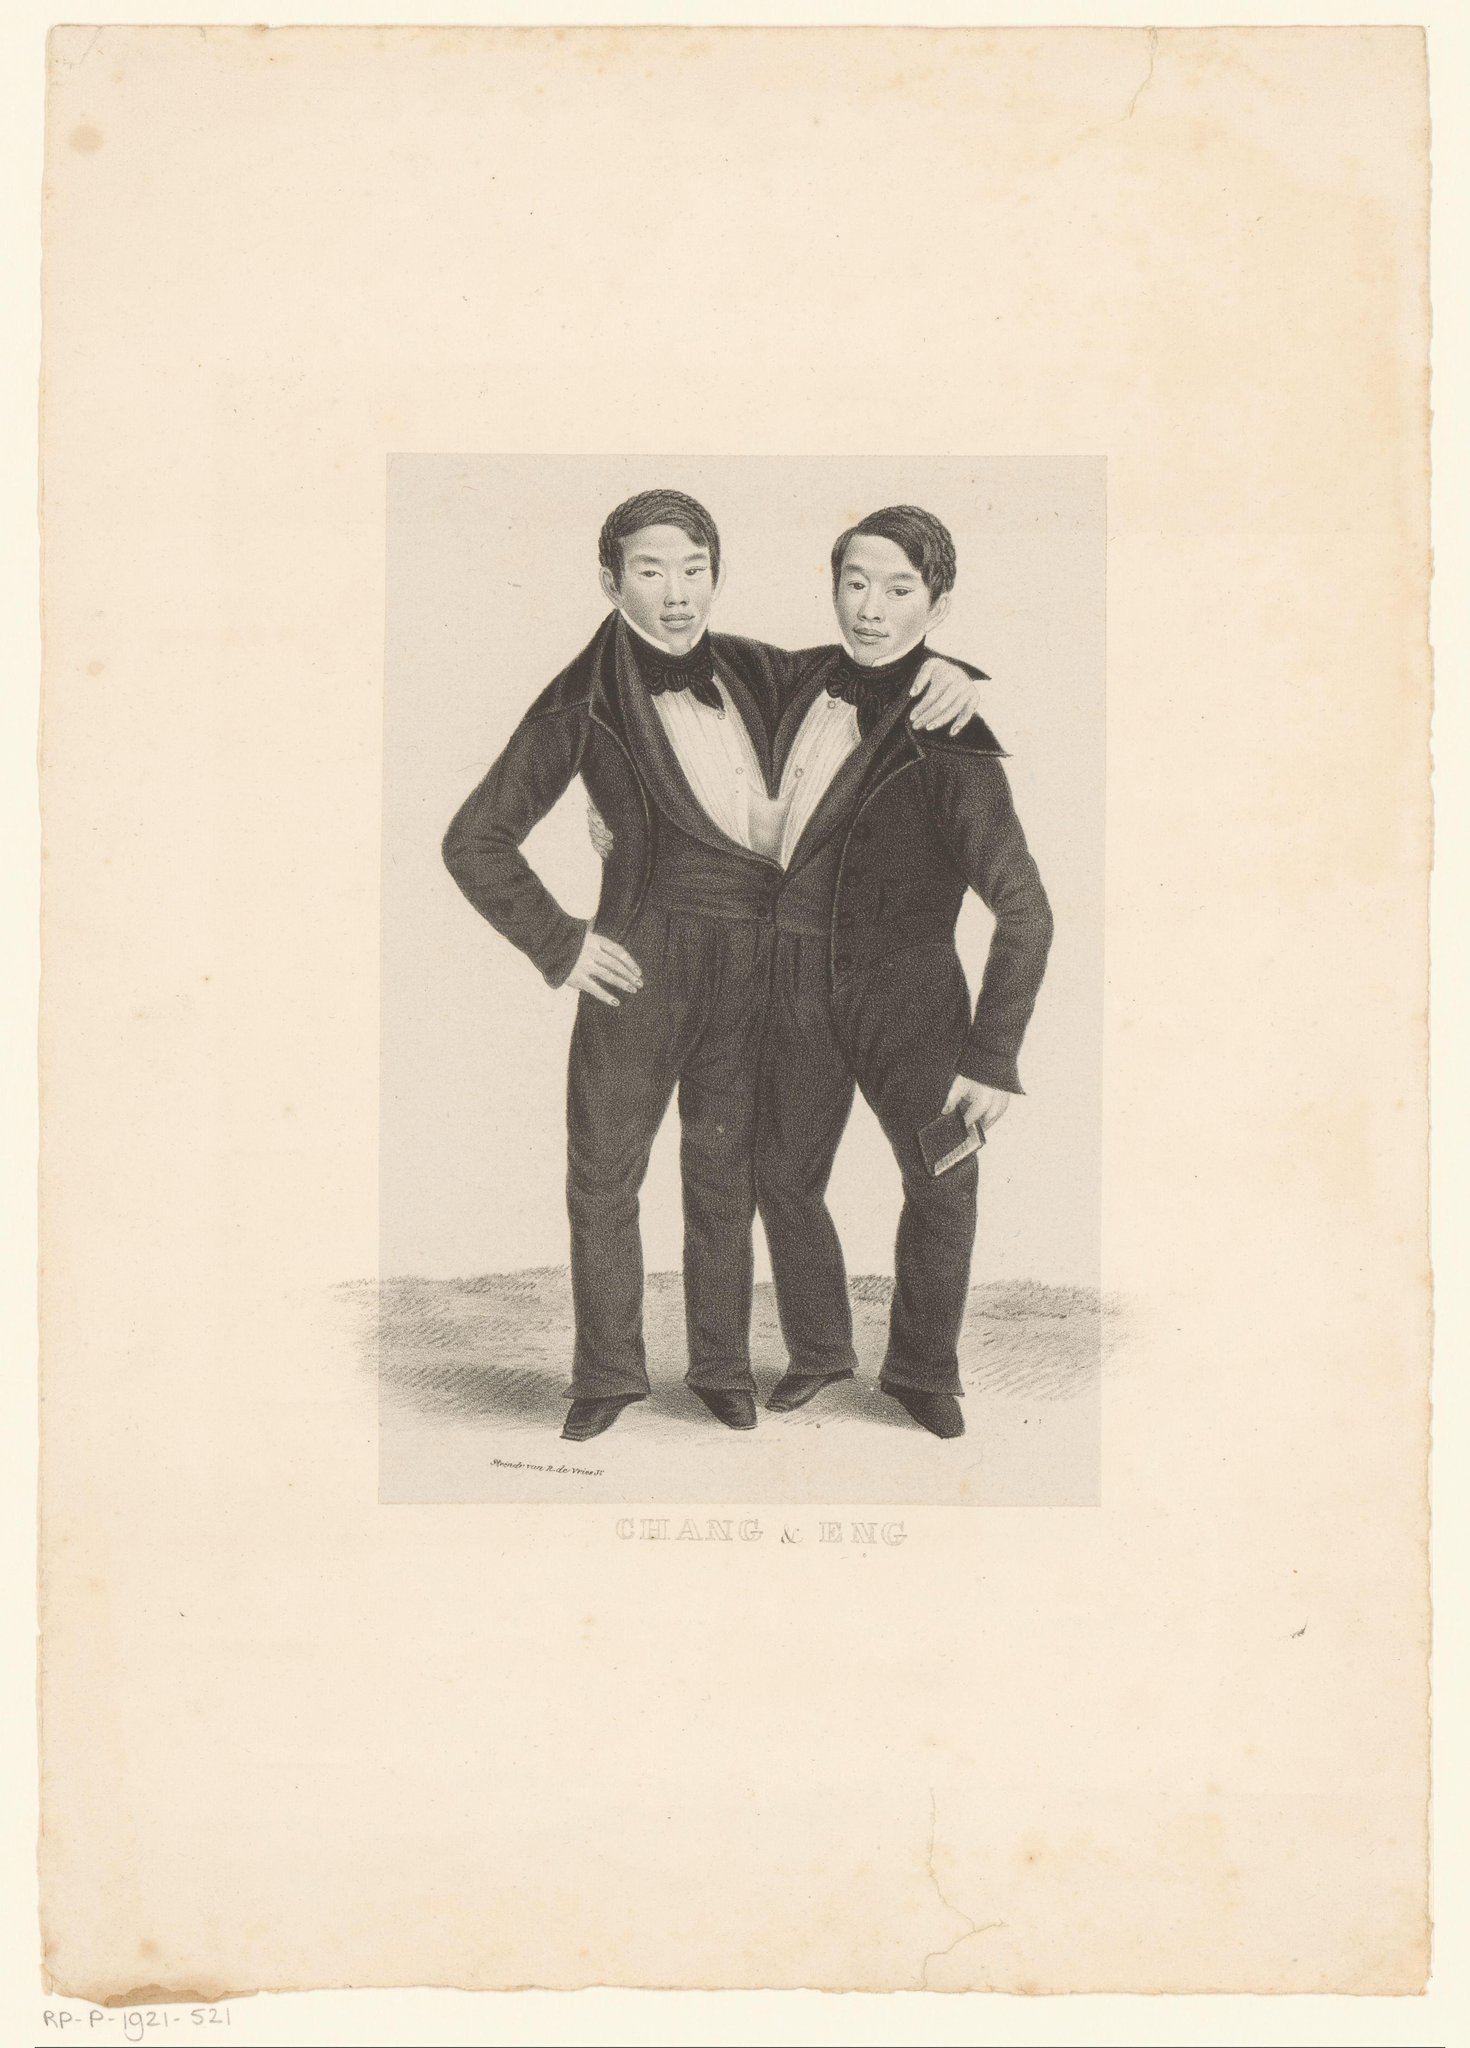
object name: print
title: Portret van Chang en Eng Bunker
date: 1834-1874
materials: paper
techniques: lithograph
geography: amsterdam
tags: thailand, historical persons, siamese twins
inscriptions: collector's mark: Lugt 2233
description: De beroemd geworden bijnaam ‘Siamese tweeling’ is door (populaire) media overgenomen om te verwijzen naar met elkaar vergroeide tweelingen.